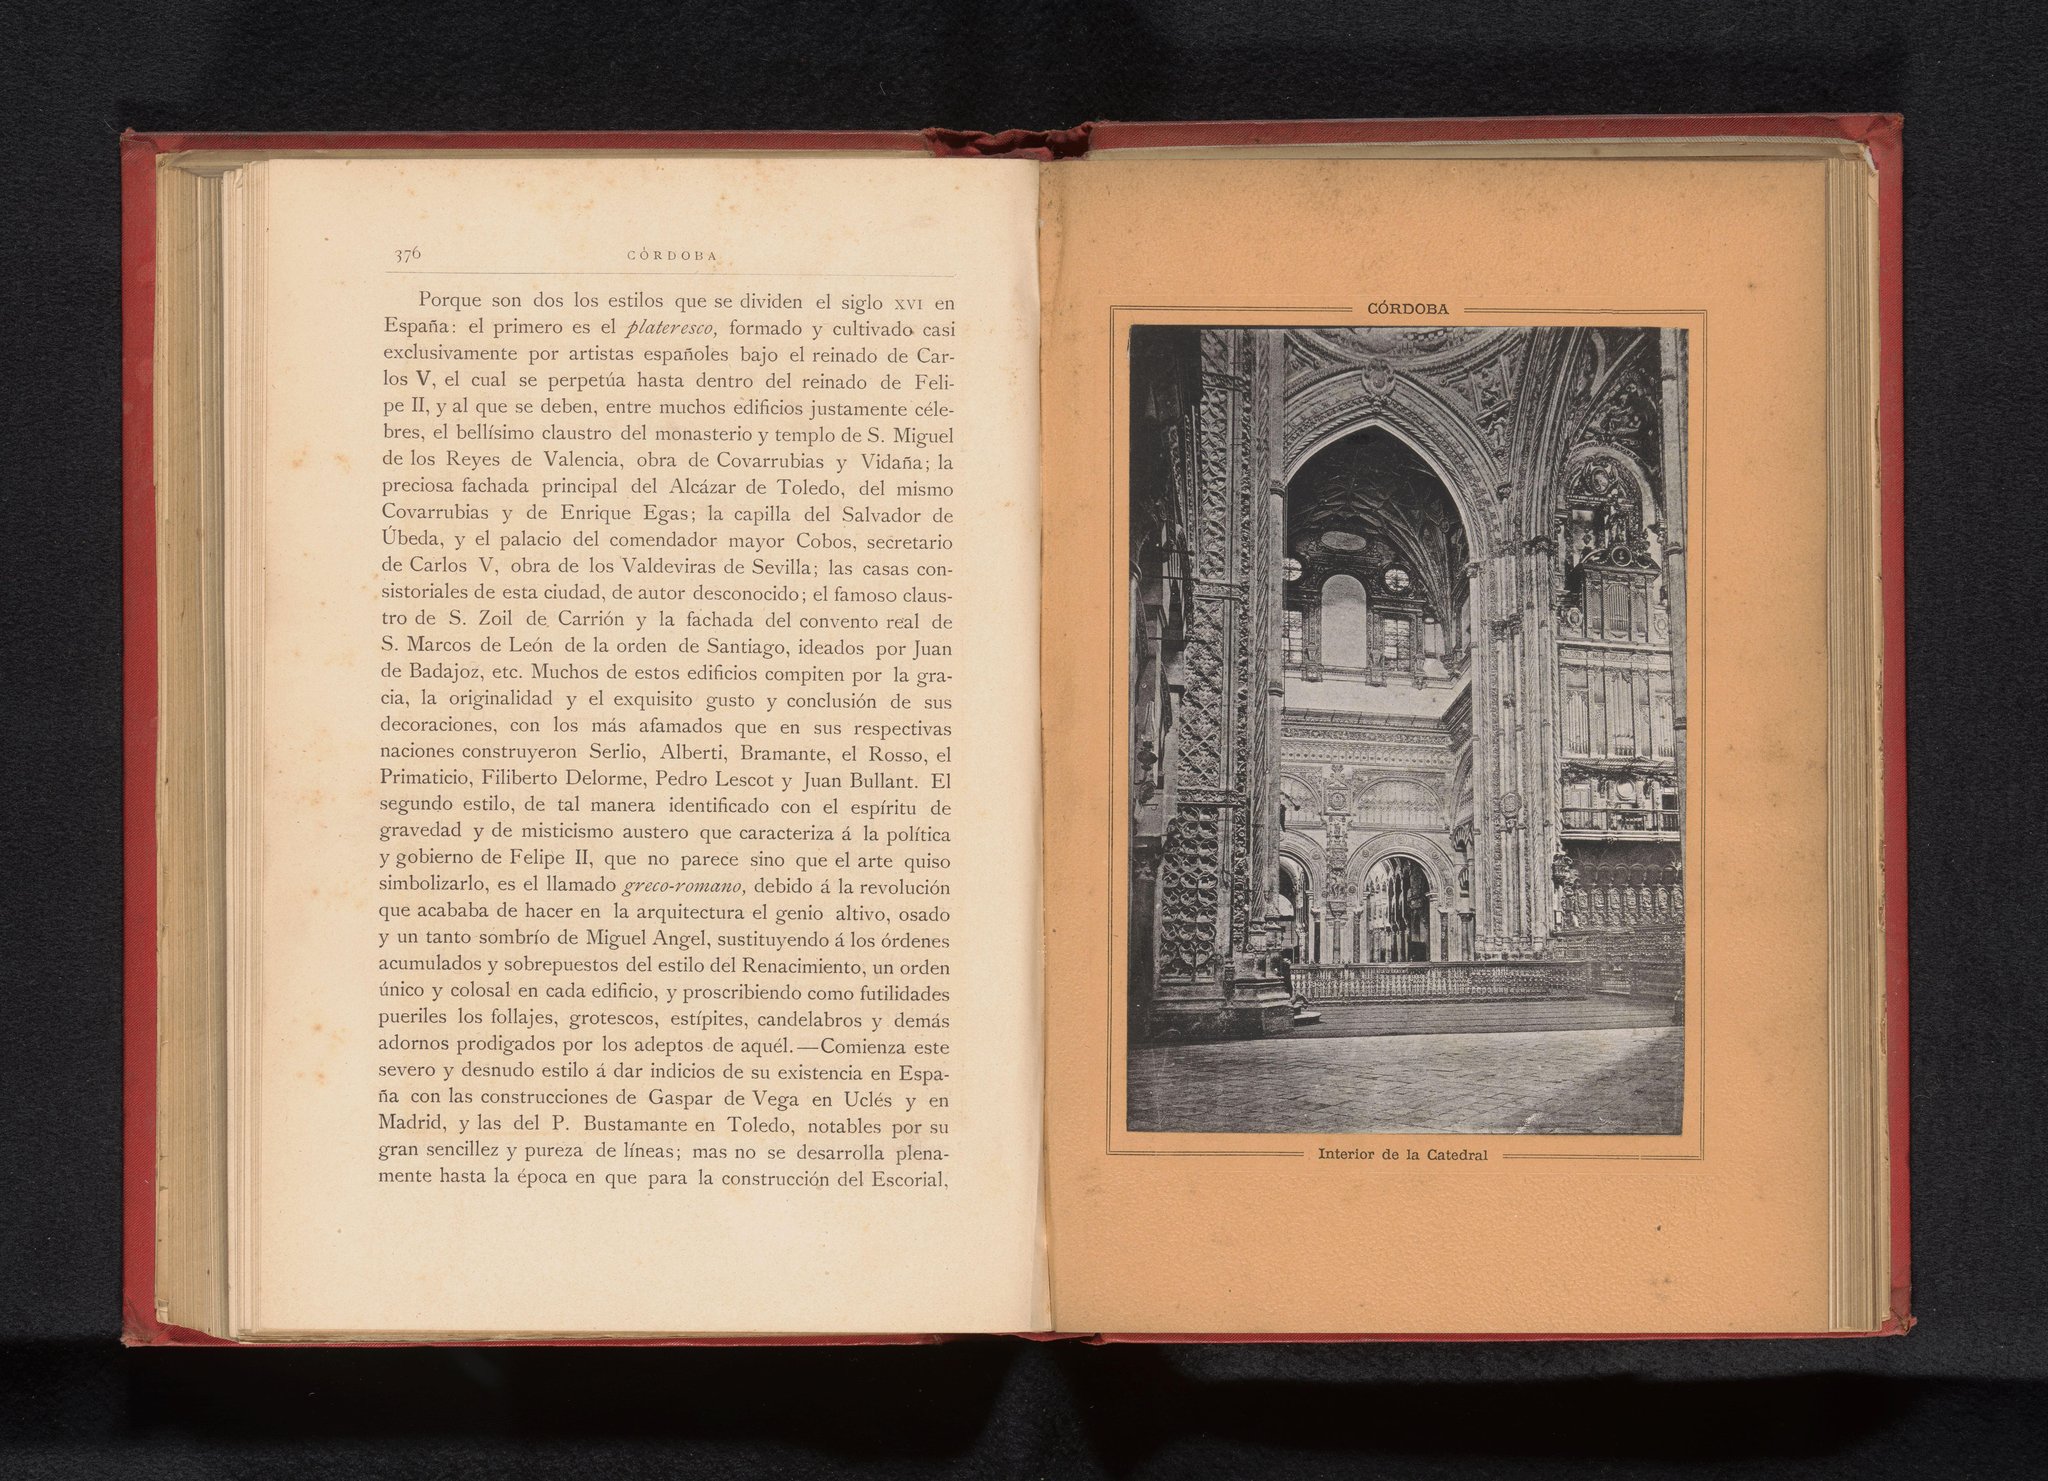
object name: page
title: Interior de la Catedral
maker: Anonymous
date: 1874-1884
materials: paper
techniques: photograph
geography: mezquita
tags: interior of church